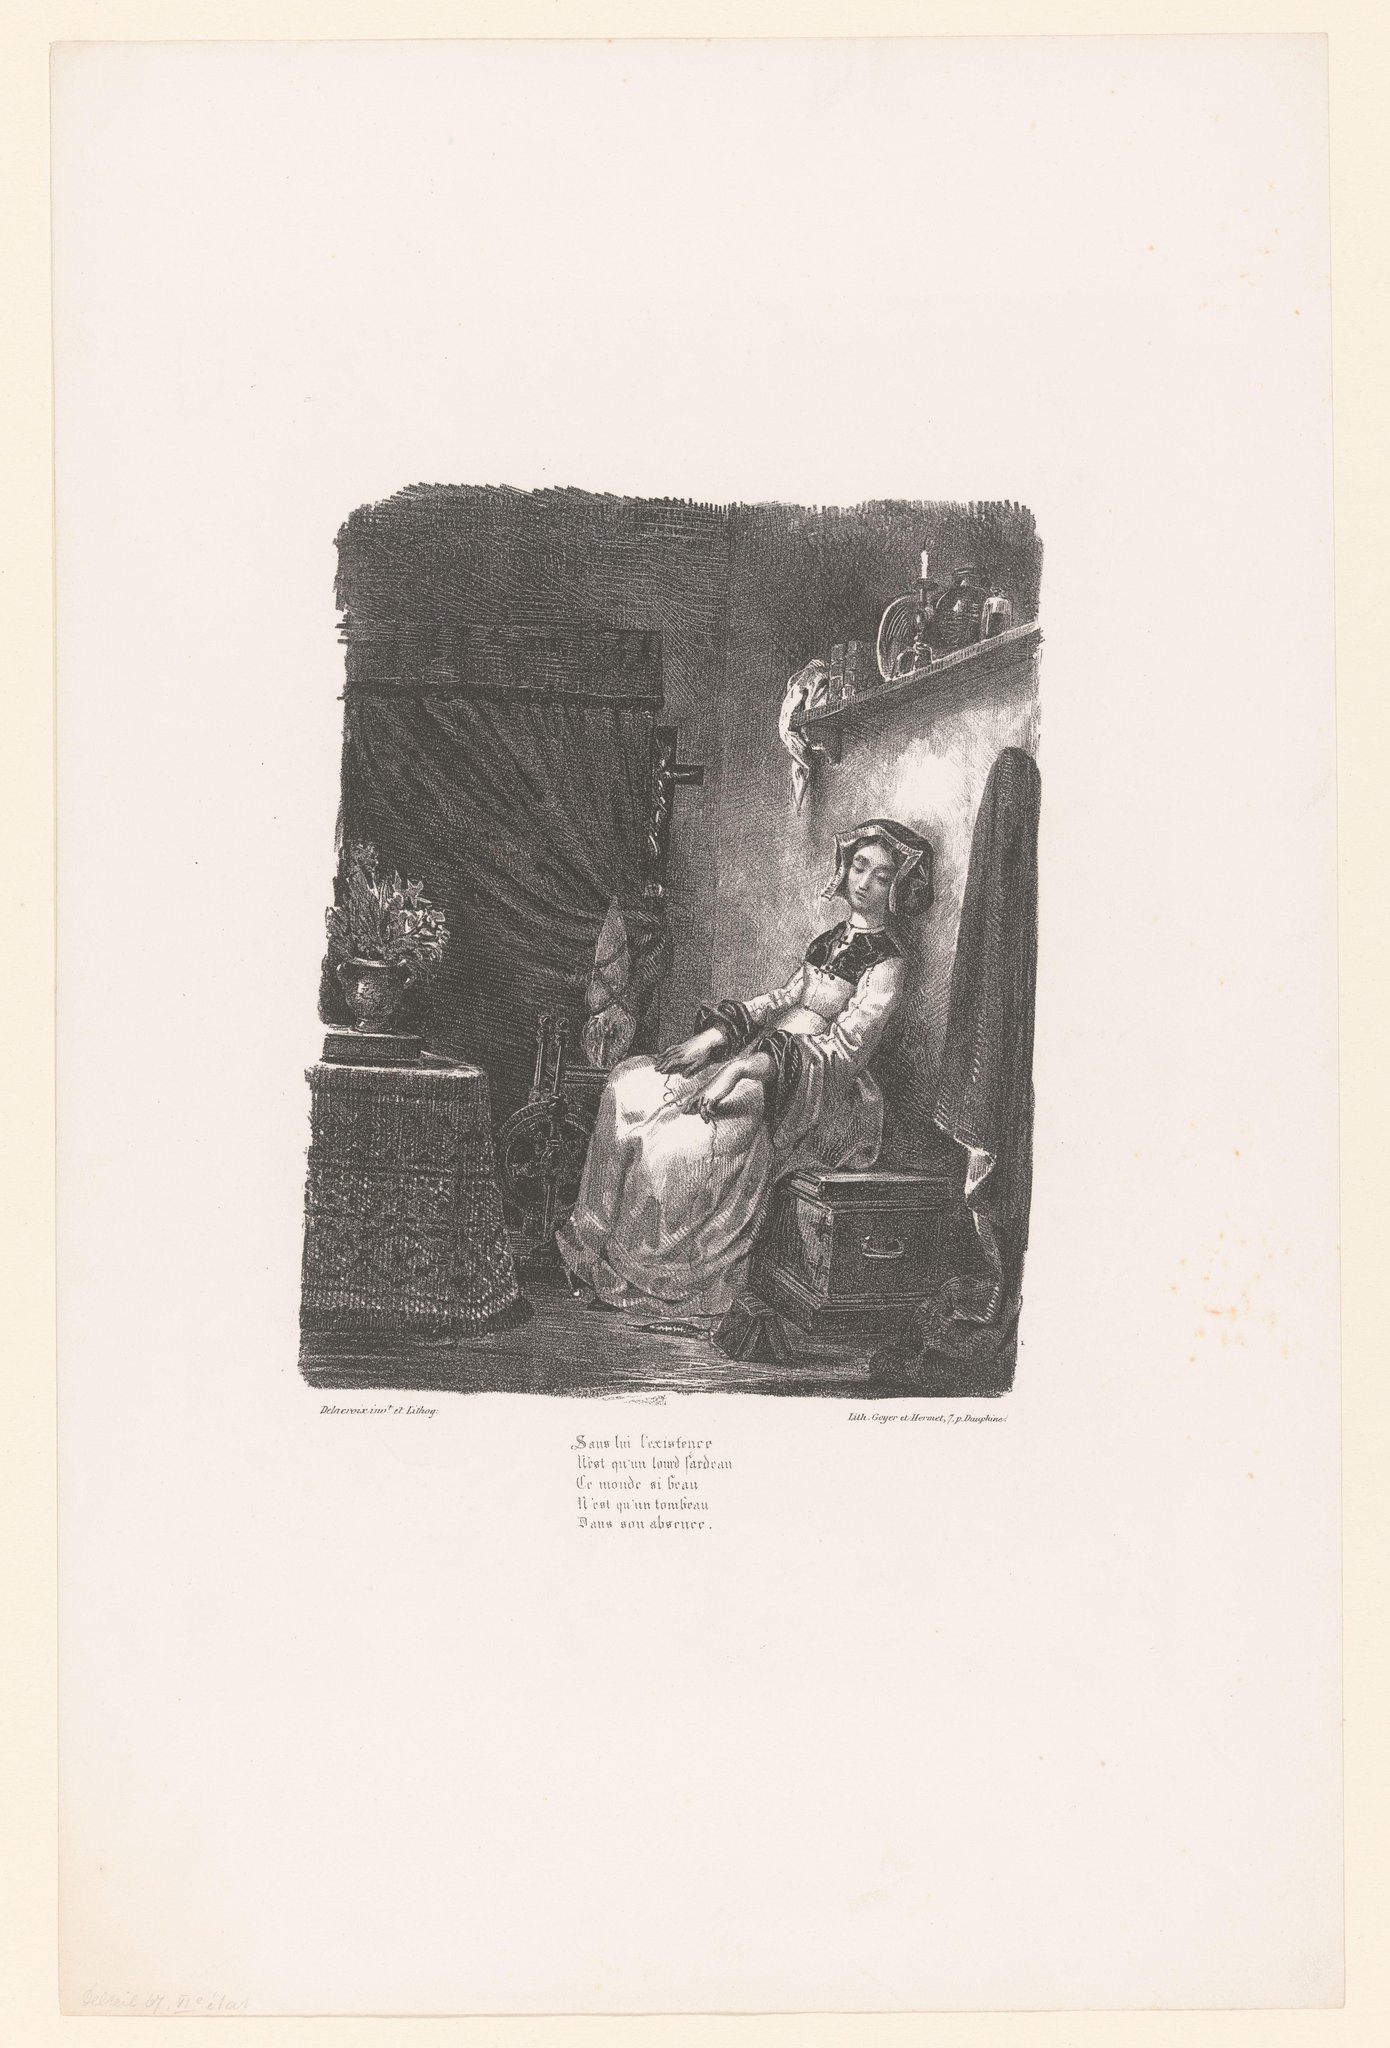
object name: print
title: Faust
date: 1828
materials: paper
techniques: lithograph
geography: paris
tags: (scenes from) specific works of literature: goethe, faust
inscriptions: collector's mark: Lugt 2228a, collector's mark: Lugt 964